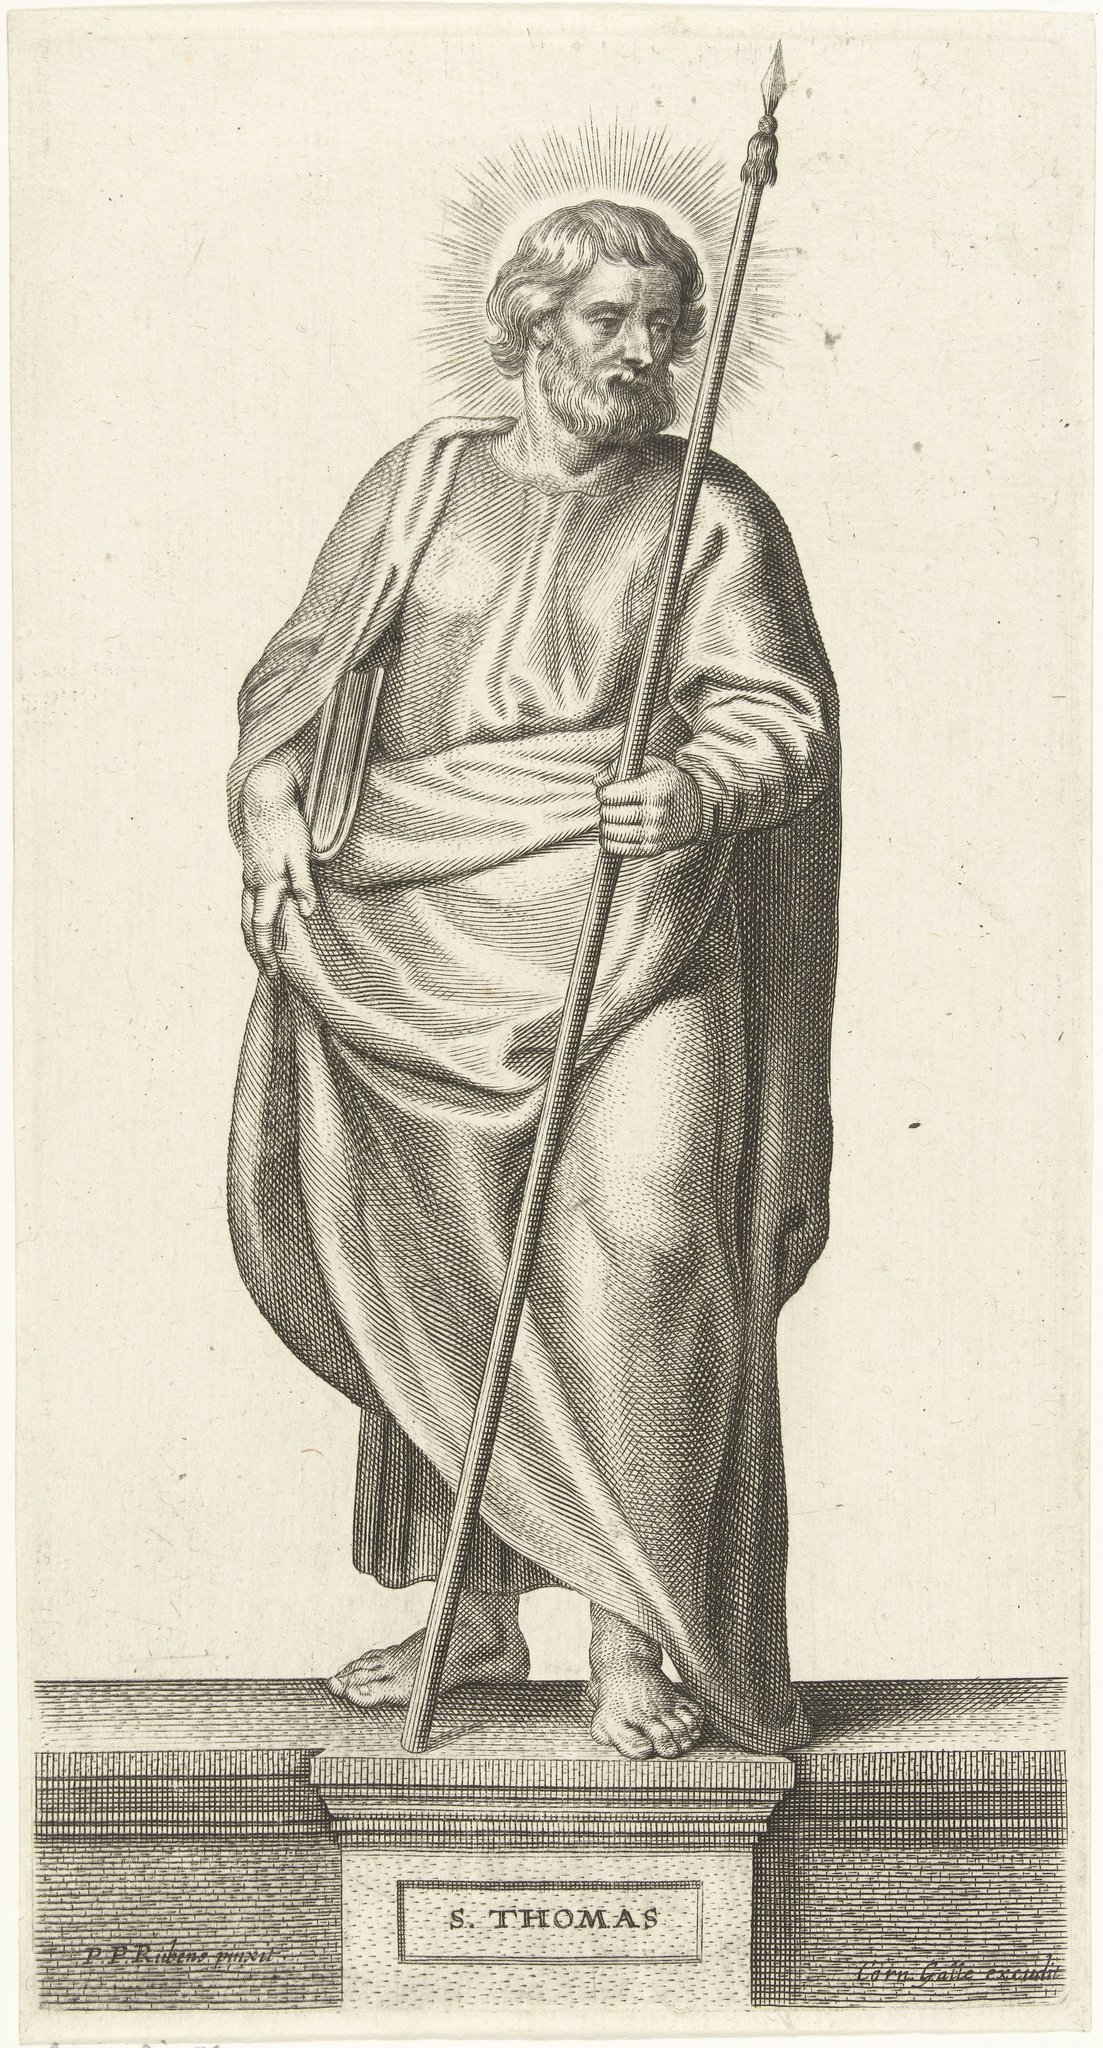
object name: print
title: SS Apostolorum Iconen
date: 1639-1670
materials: paper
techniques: engraving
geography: antwerp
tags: the apostle thomas; possible attributes: book, chalice, girdle, heart, lance or spear, scroll, square, stones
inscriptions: collector's mark: Lugt 240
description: De prent toont de Heilige Thomas. In zijn linkerhand een speer. In zijn rechterhand een boek. De serie bestaat uit prenten gebaseerd op schilderijen van Peter Paul Rubens.